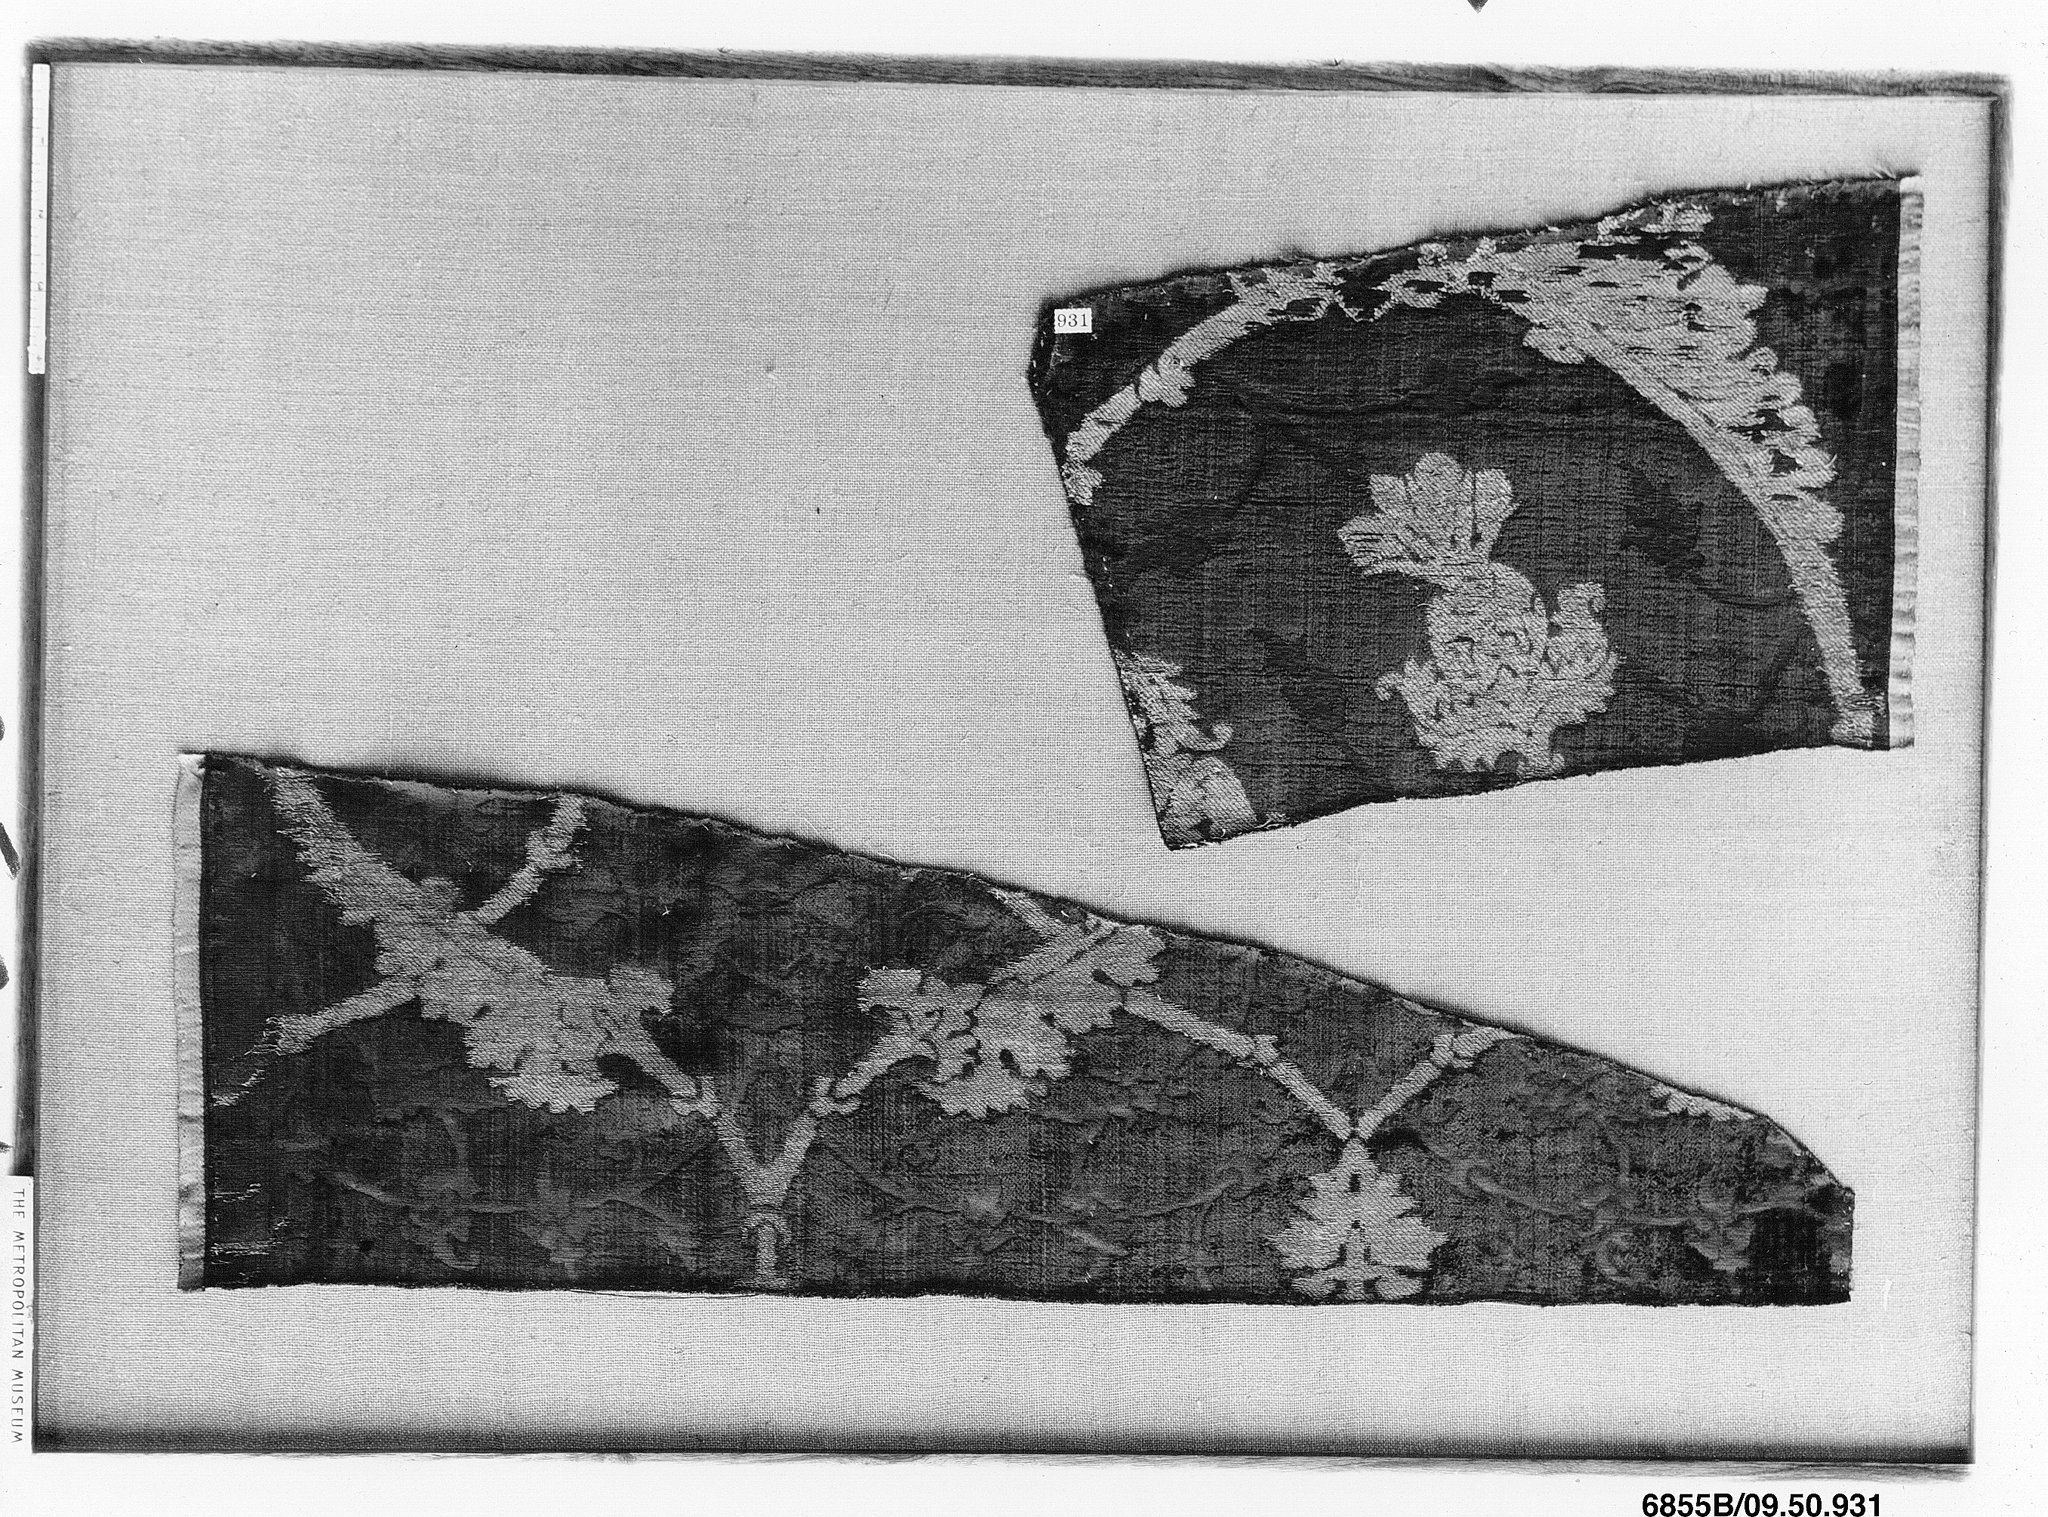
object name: piece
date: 1401-1600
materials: metal thread, silk